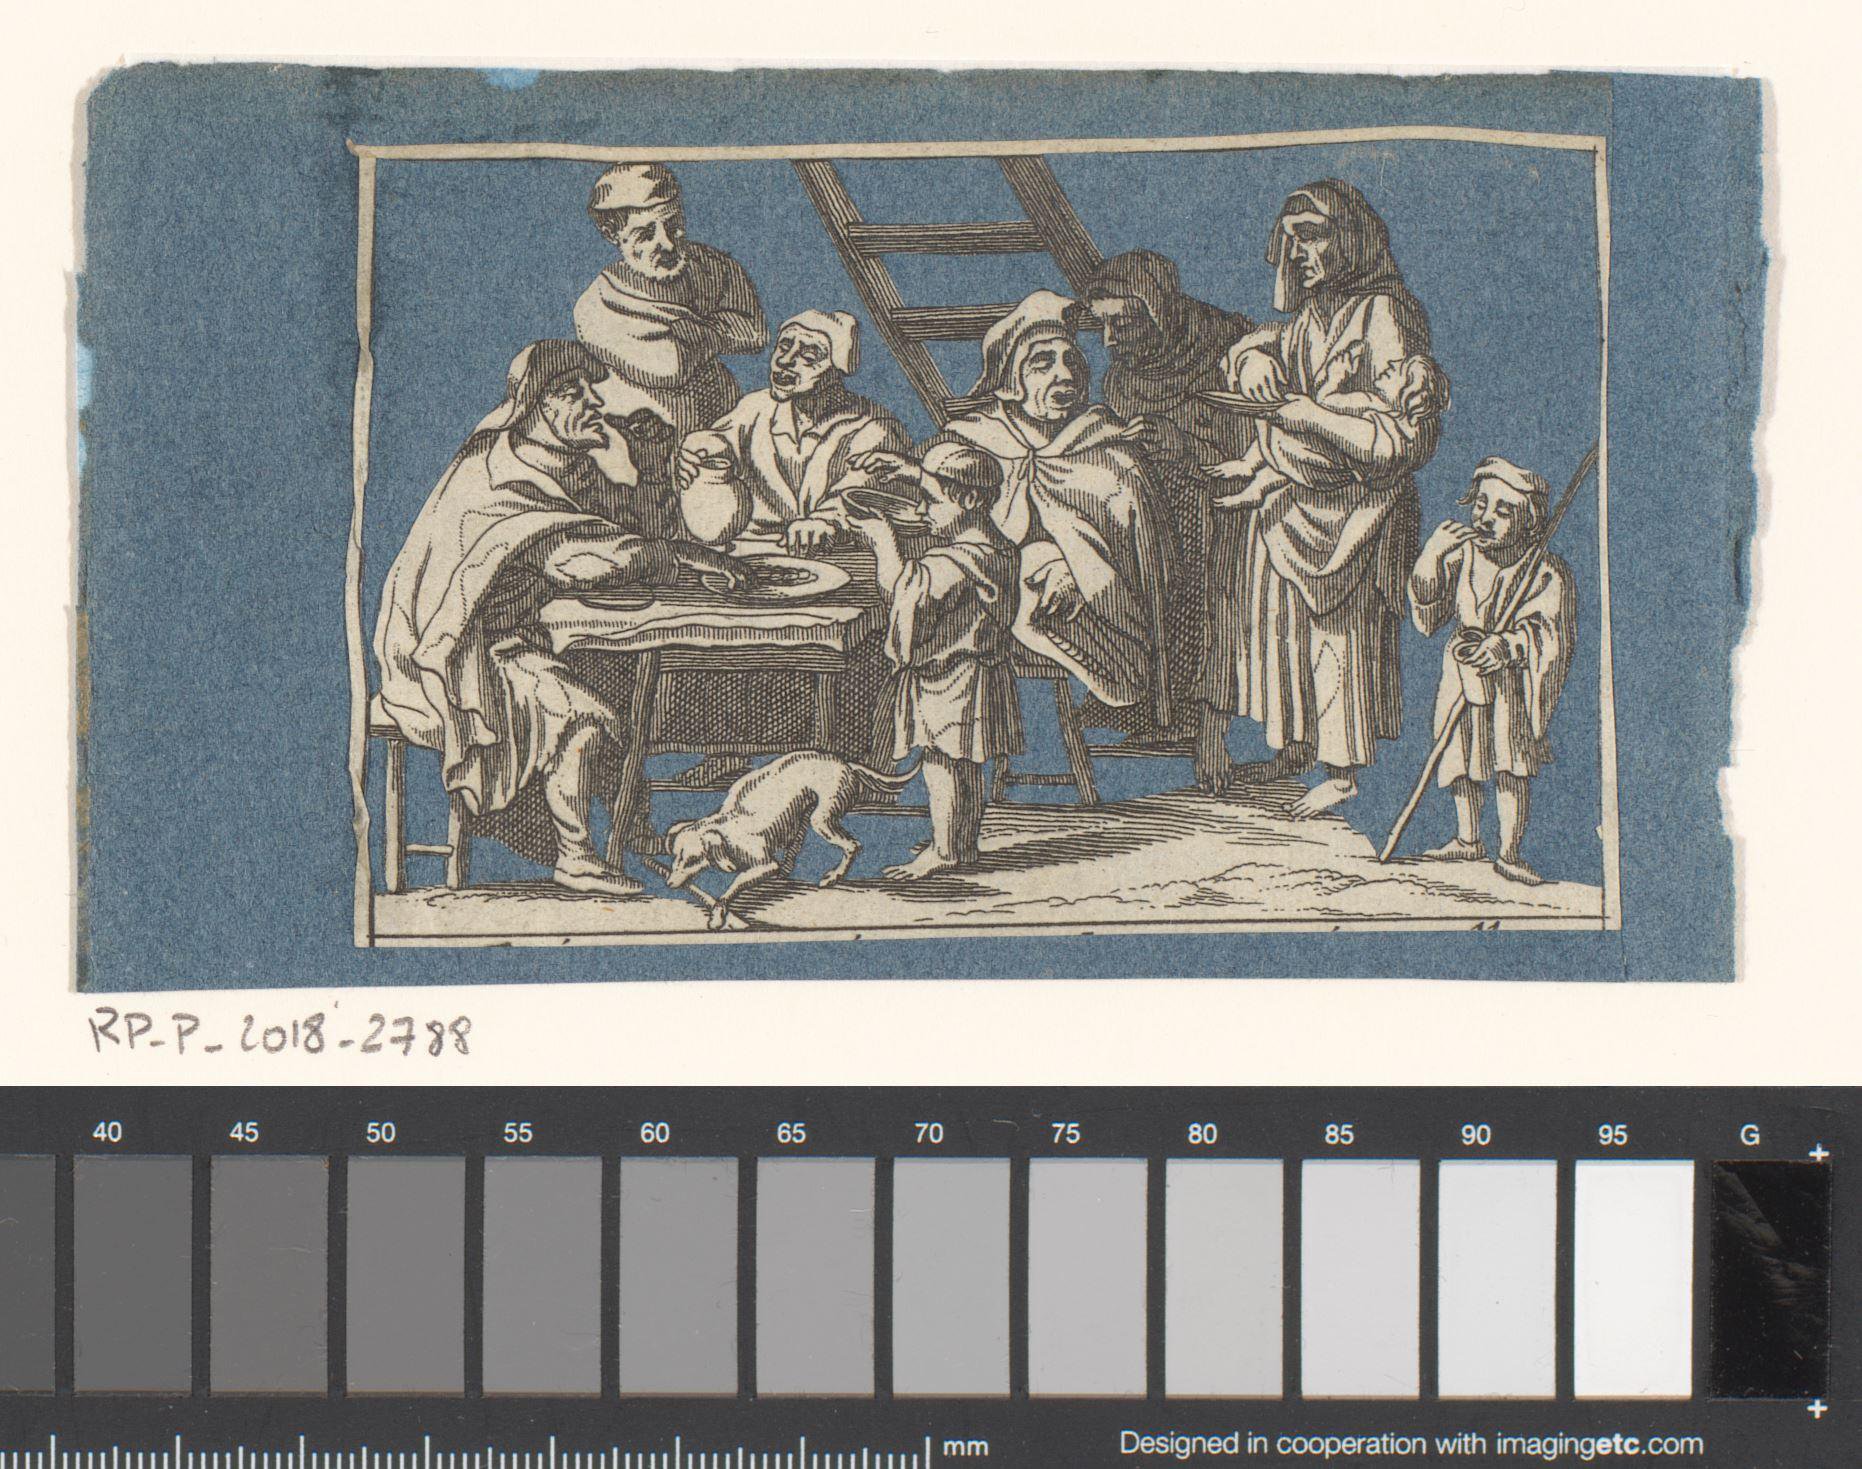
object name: print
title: Fragment van een collage van uitgeknipte prenten, geplakt op blauw papier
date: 1680-1720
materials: paper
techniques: etching, snipping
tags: blind, blindness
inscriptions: collector's mark: Lugt 2760, collector's mark: Lugt 2228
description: Groep blinden aan een tafel. Fragment van een collage van uitgeknipte prenten, geplakt op blauw papier.